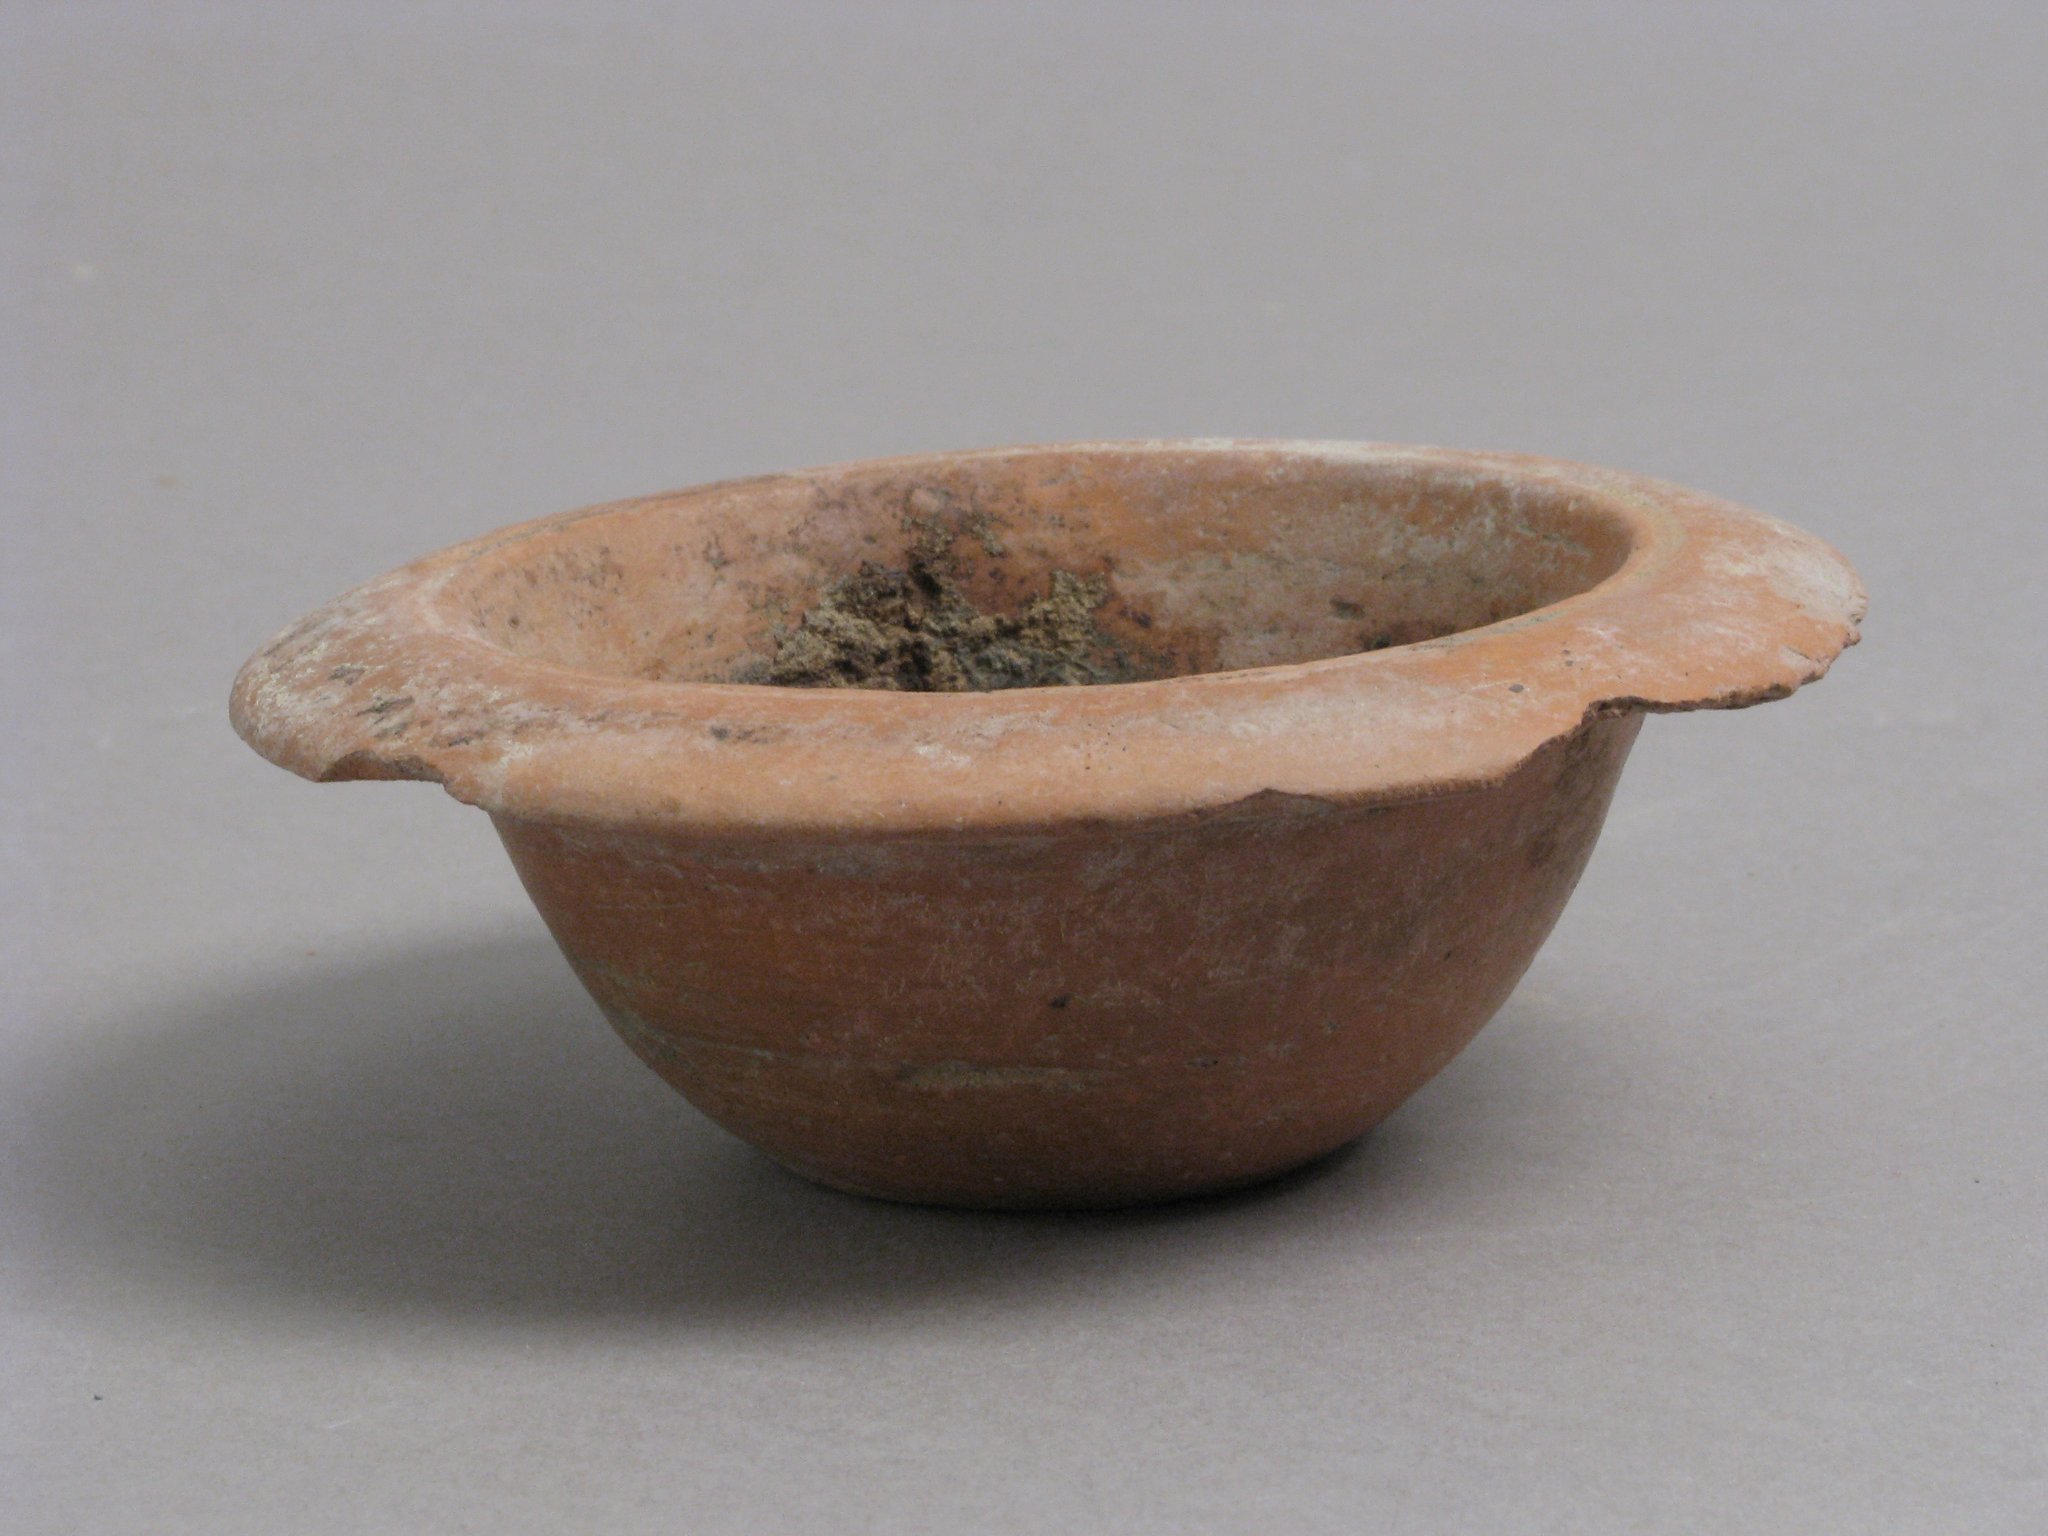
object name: bowl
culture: coptic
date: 301-700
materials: earthenware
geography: egypt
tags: bowls